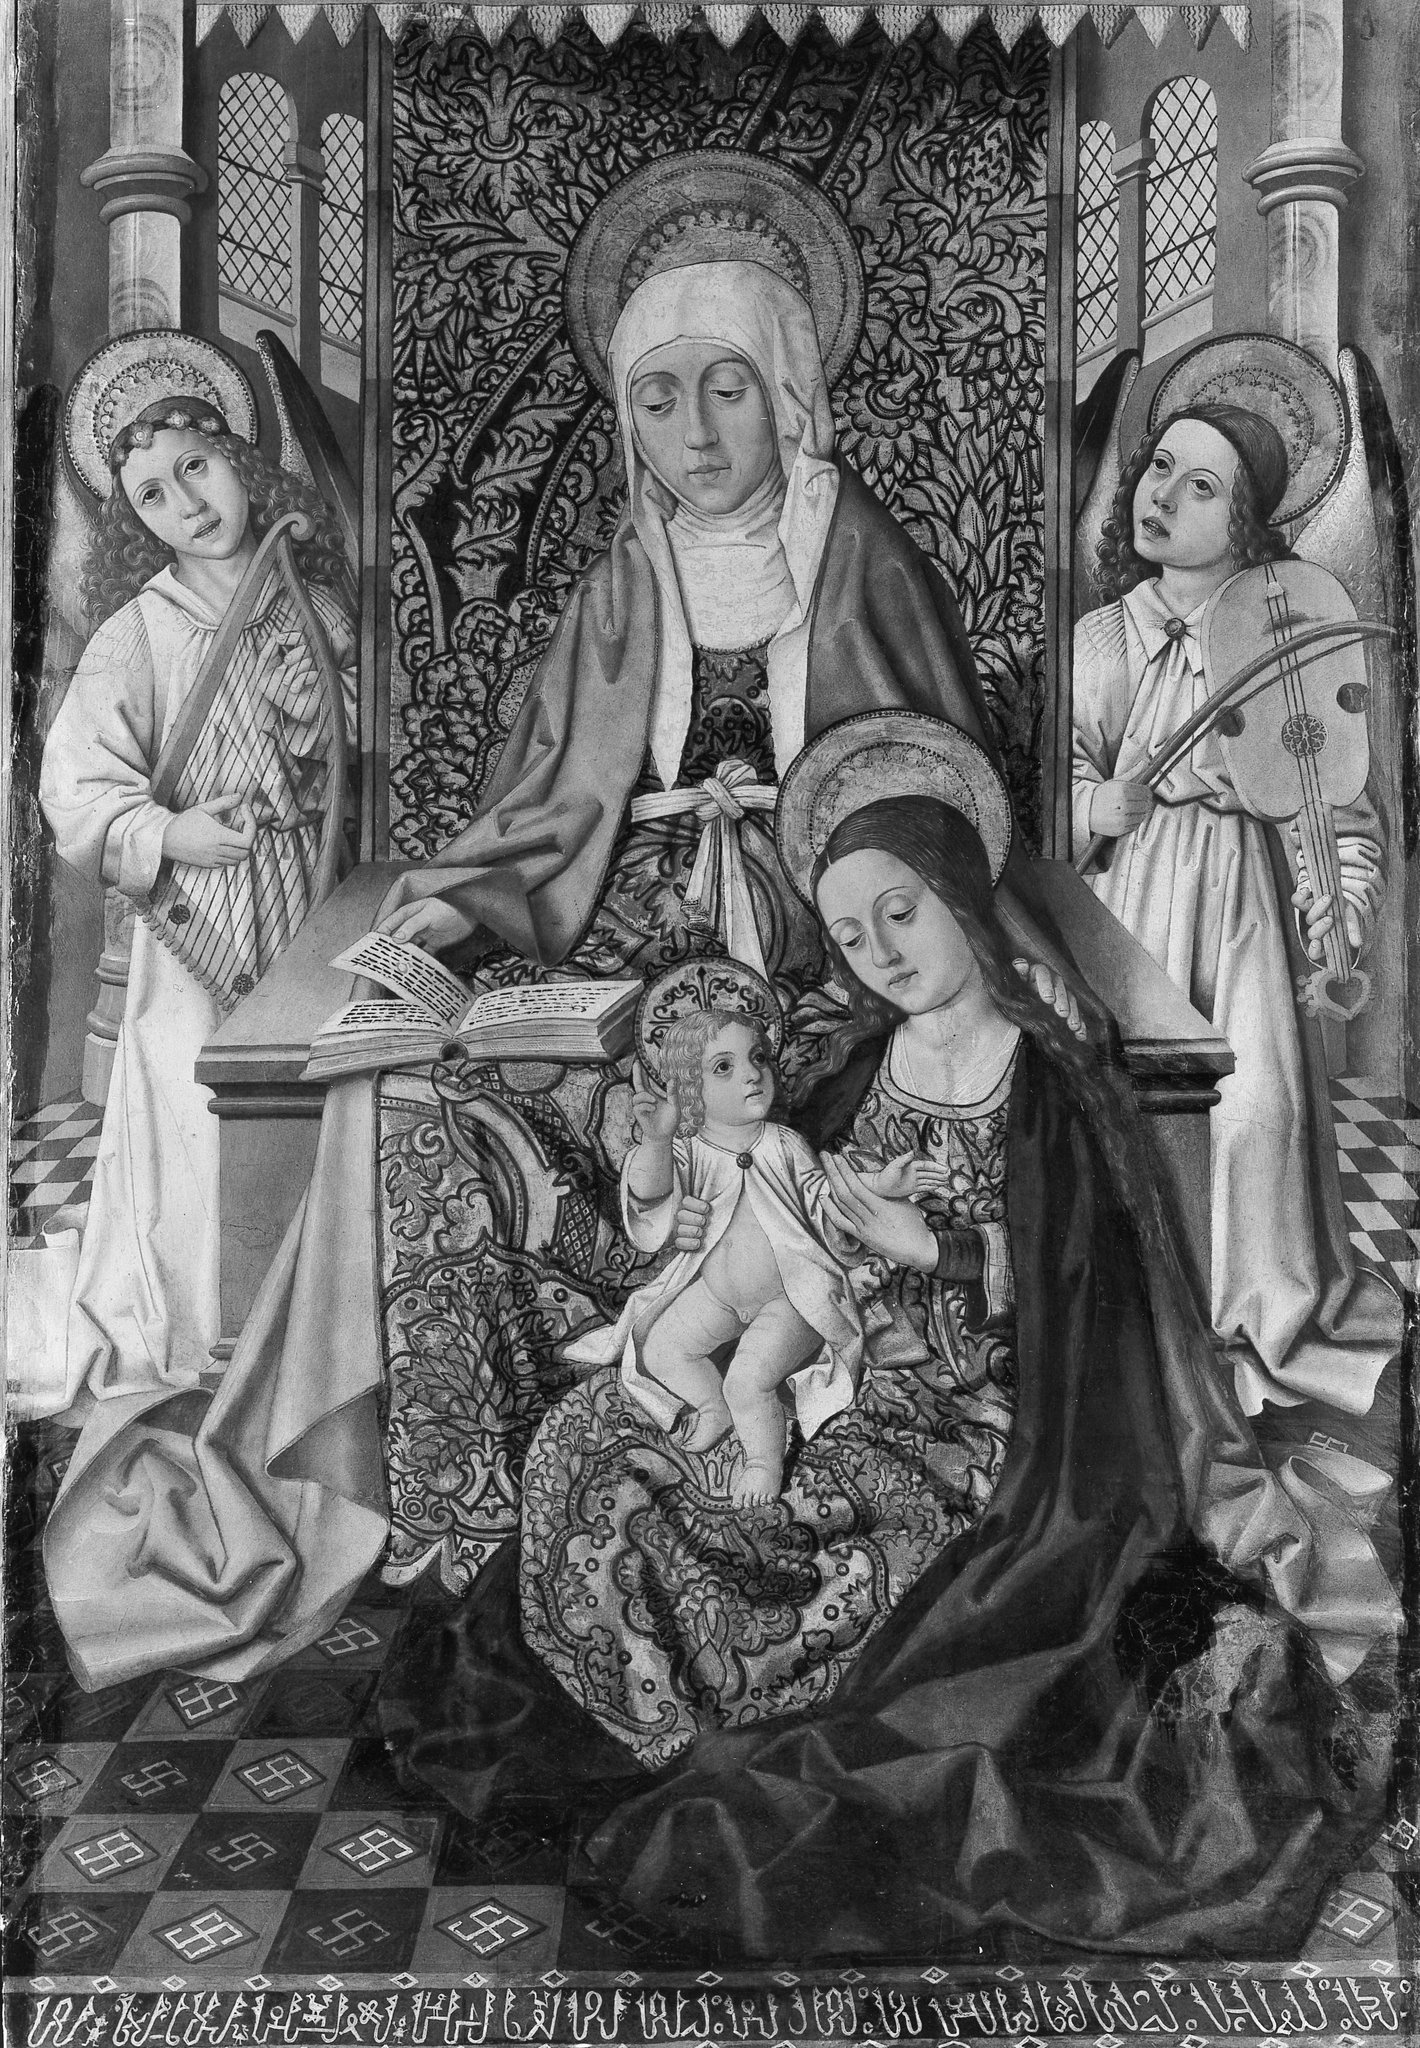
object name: painting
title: Saint Anne Enthroned with the Virgin and Child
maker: osma master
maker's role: artist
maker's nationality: spanish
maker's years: 1500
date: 1495-1505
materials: gold, paint, wood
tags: musical instruments,madonna and child,saint anne